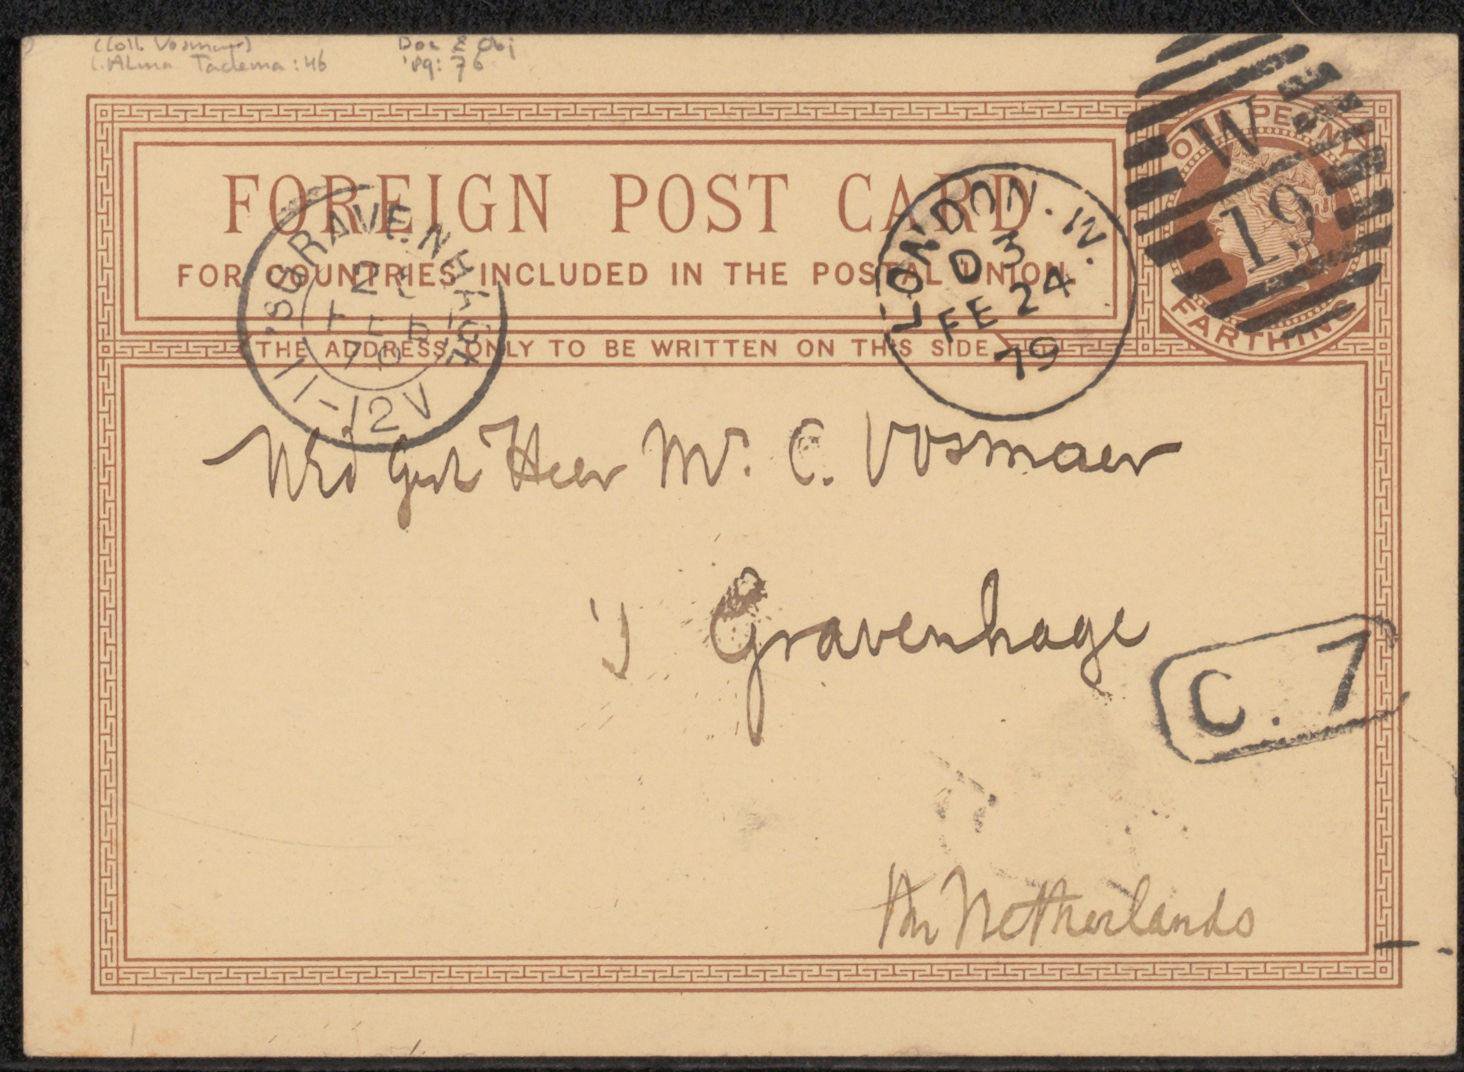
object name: postcard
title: Briefkaart aan Carel Vosmaer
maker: lourens alma tadema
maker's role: draughtsman, print maker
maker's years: 1836-1912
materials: ink, paper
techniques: pen, writing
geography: london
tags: carel vosmaer